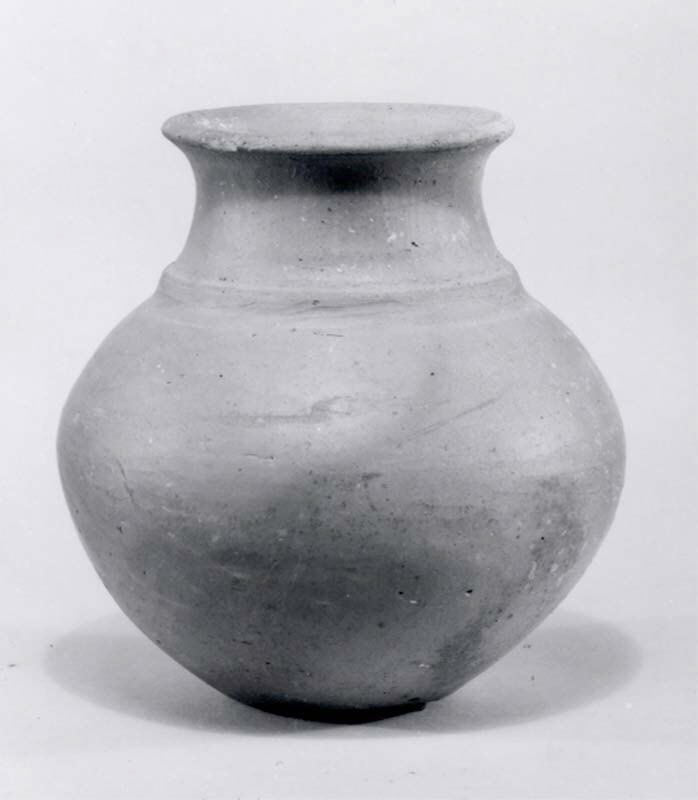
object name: jar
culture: iranian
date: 900-801 BCE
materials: ceramic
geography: iran